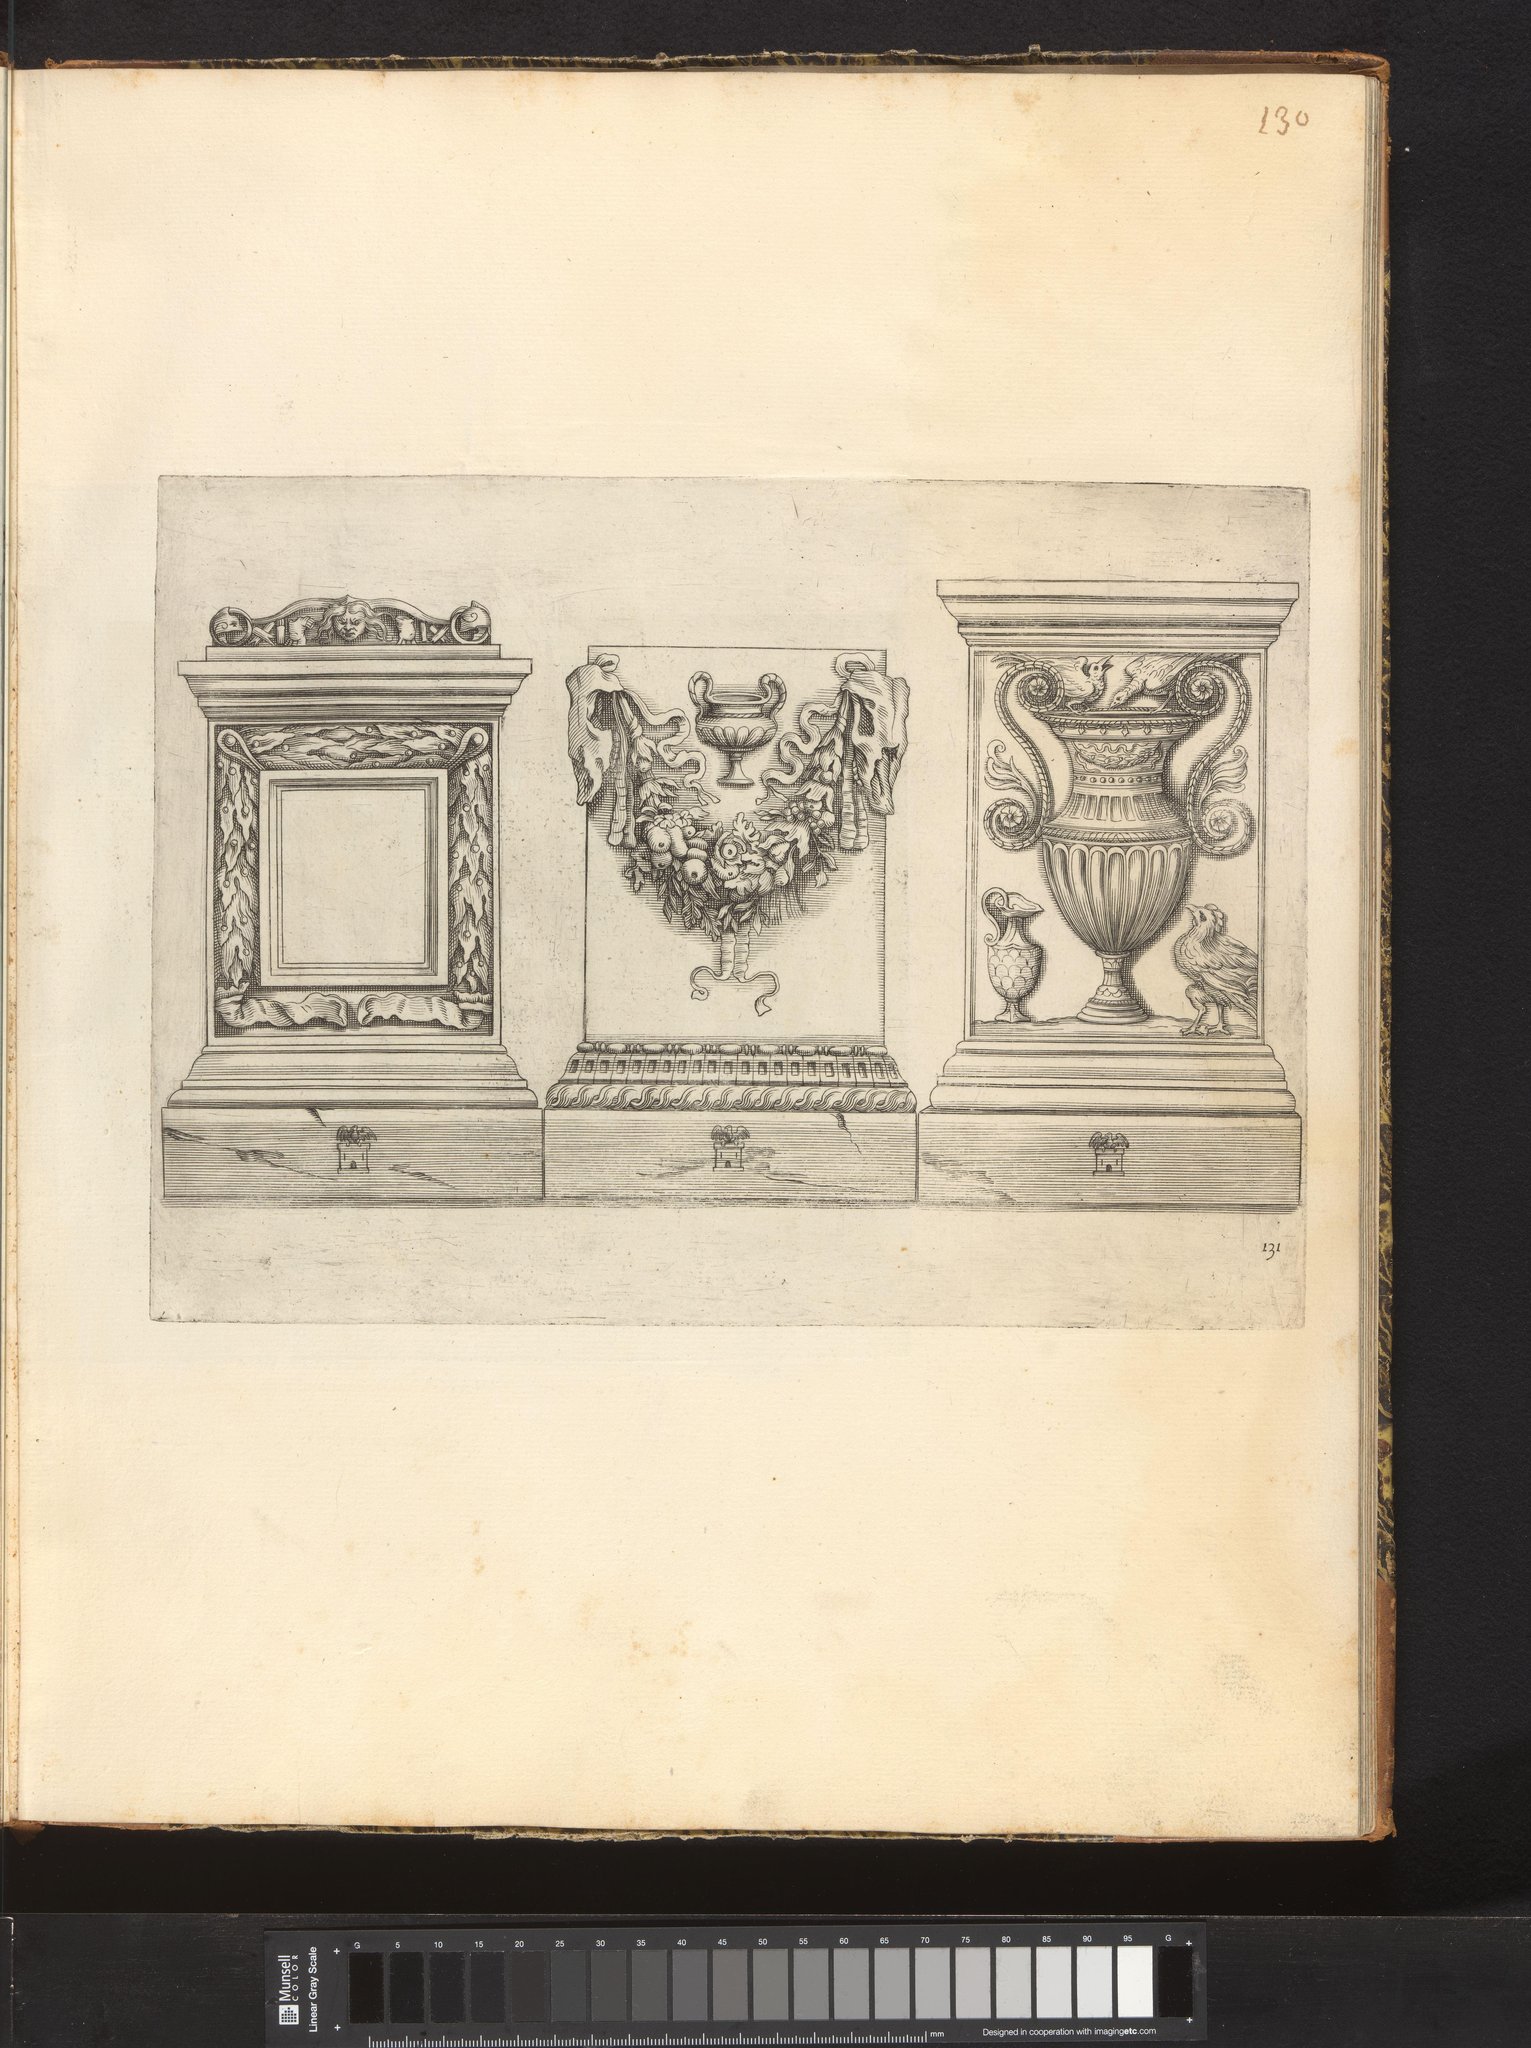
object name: album leaf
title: Bas-reliëf met voorstelling van een strijd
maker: valérien regnard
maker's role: print maker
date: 1636-1647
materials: paper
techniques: engraving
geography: rome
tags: battle, fighting in general, piece of sculpture, reproduction of a piece of sculpture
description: Bas-reliëf met voorstelling van een strijd. Soldaten te paard strijden met elkaar. Enkele soldaten gaan te voet. Geheel onder liggen slachtoffers. Geheel links en rechts een krijgsgevangene. Middenonder het wapenschild van Vincenzo Giustiniani. Prent maakt deel uit van een album met een serie prenten naar de sculpturen in de verzameling in de Galleria Giustiniani te Rome.